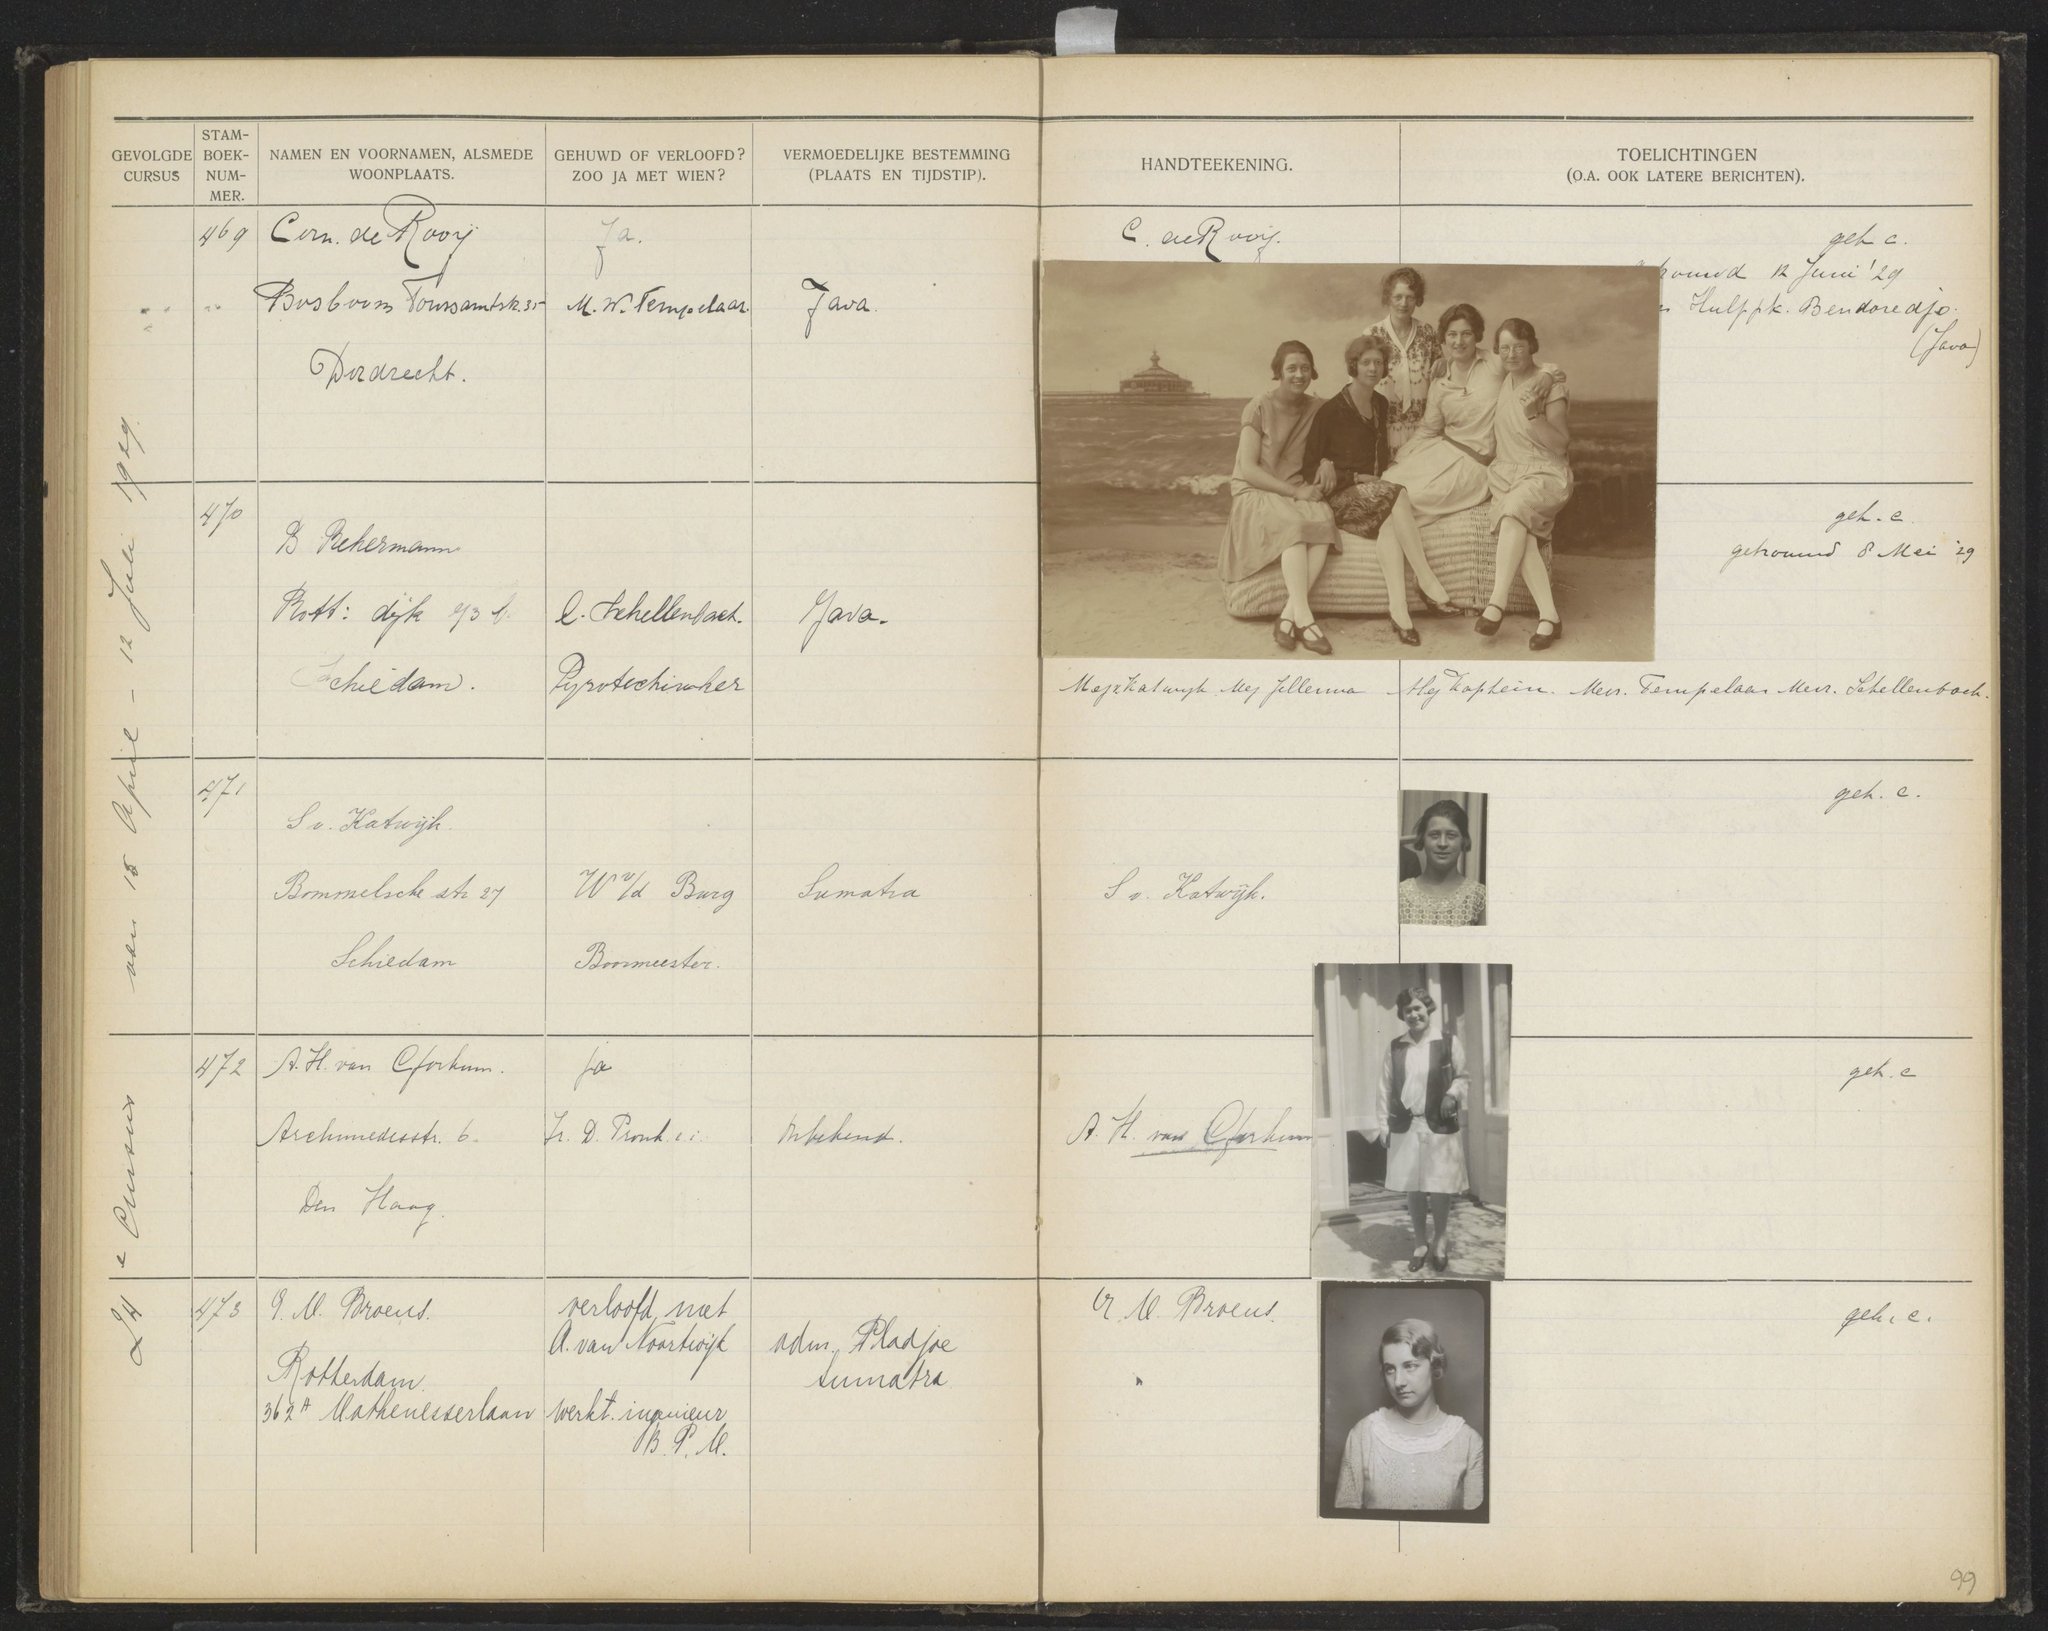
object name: album leaf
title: Blad 99 uit Stamboek van de leerlingen der Koloniale School voor Meisjes en Vrouwen te 's-Gravenhage deel I (1921-1929)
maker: Anonymous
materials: paper, photographic support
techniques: photography, printing, writing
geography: the hague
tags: further education (+ pupil), further education, the hague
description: Twee pagina's met gegevens van de deelnemers aan de 24e driemaandelijkse cursus van 15 april tot en met 12 juli 1929, stamboeknummers 469 tot en met 473. Onderdeel van Stamboek van de leerlingen der Koloniale School voor Meisjes en Vrouwen te 's-Gravenhage deel I (1921-1929).